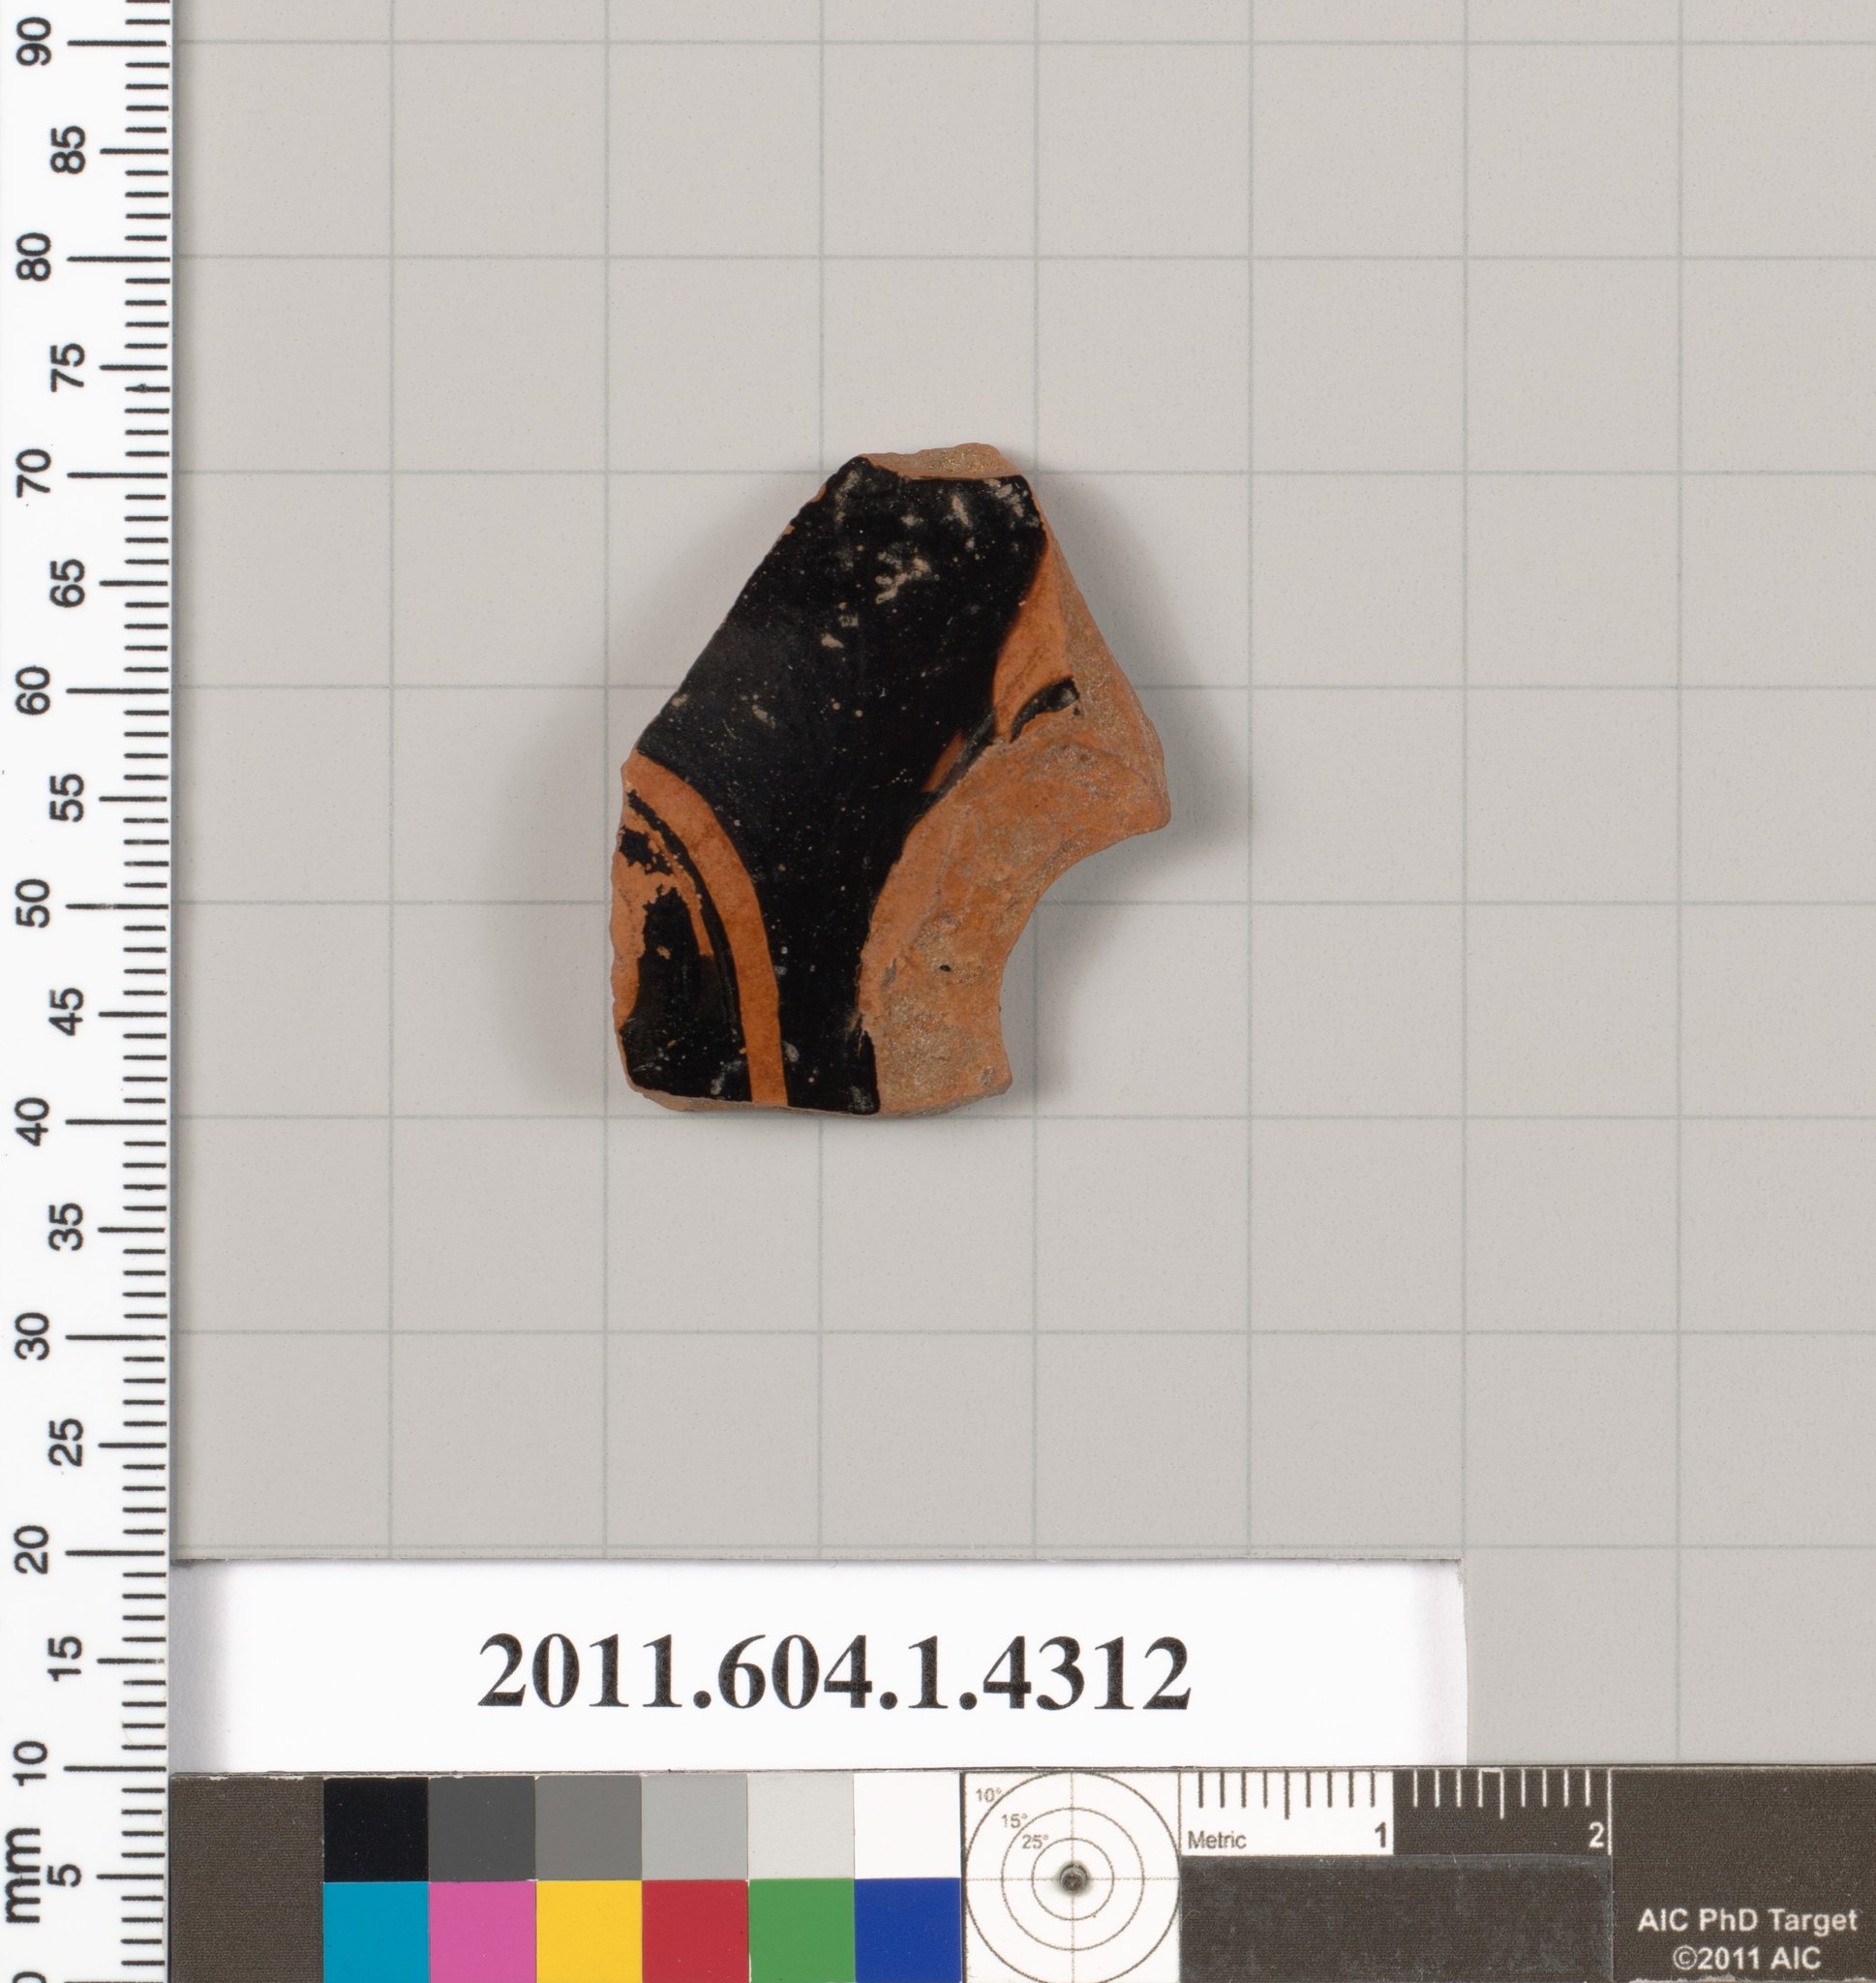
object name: kylix fragment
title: Terracotta fragment of a kylix (drinking cup)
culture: greek, attic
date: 500-451 BCE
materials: terracotta